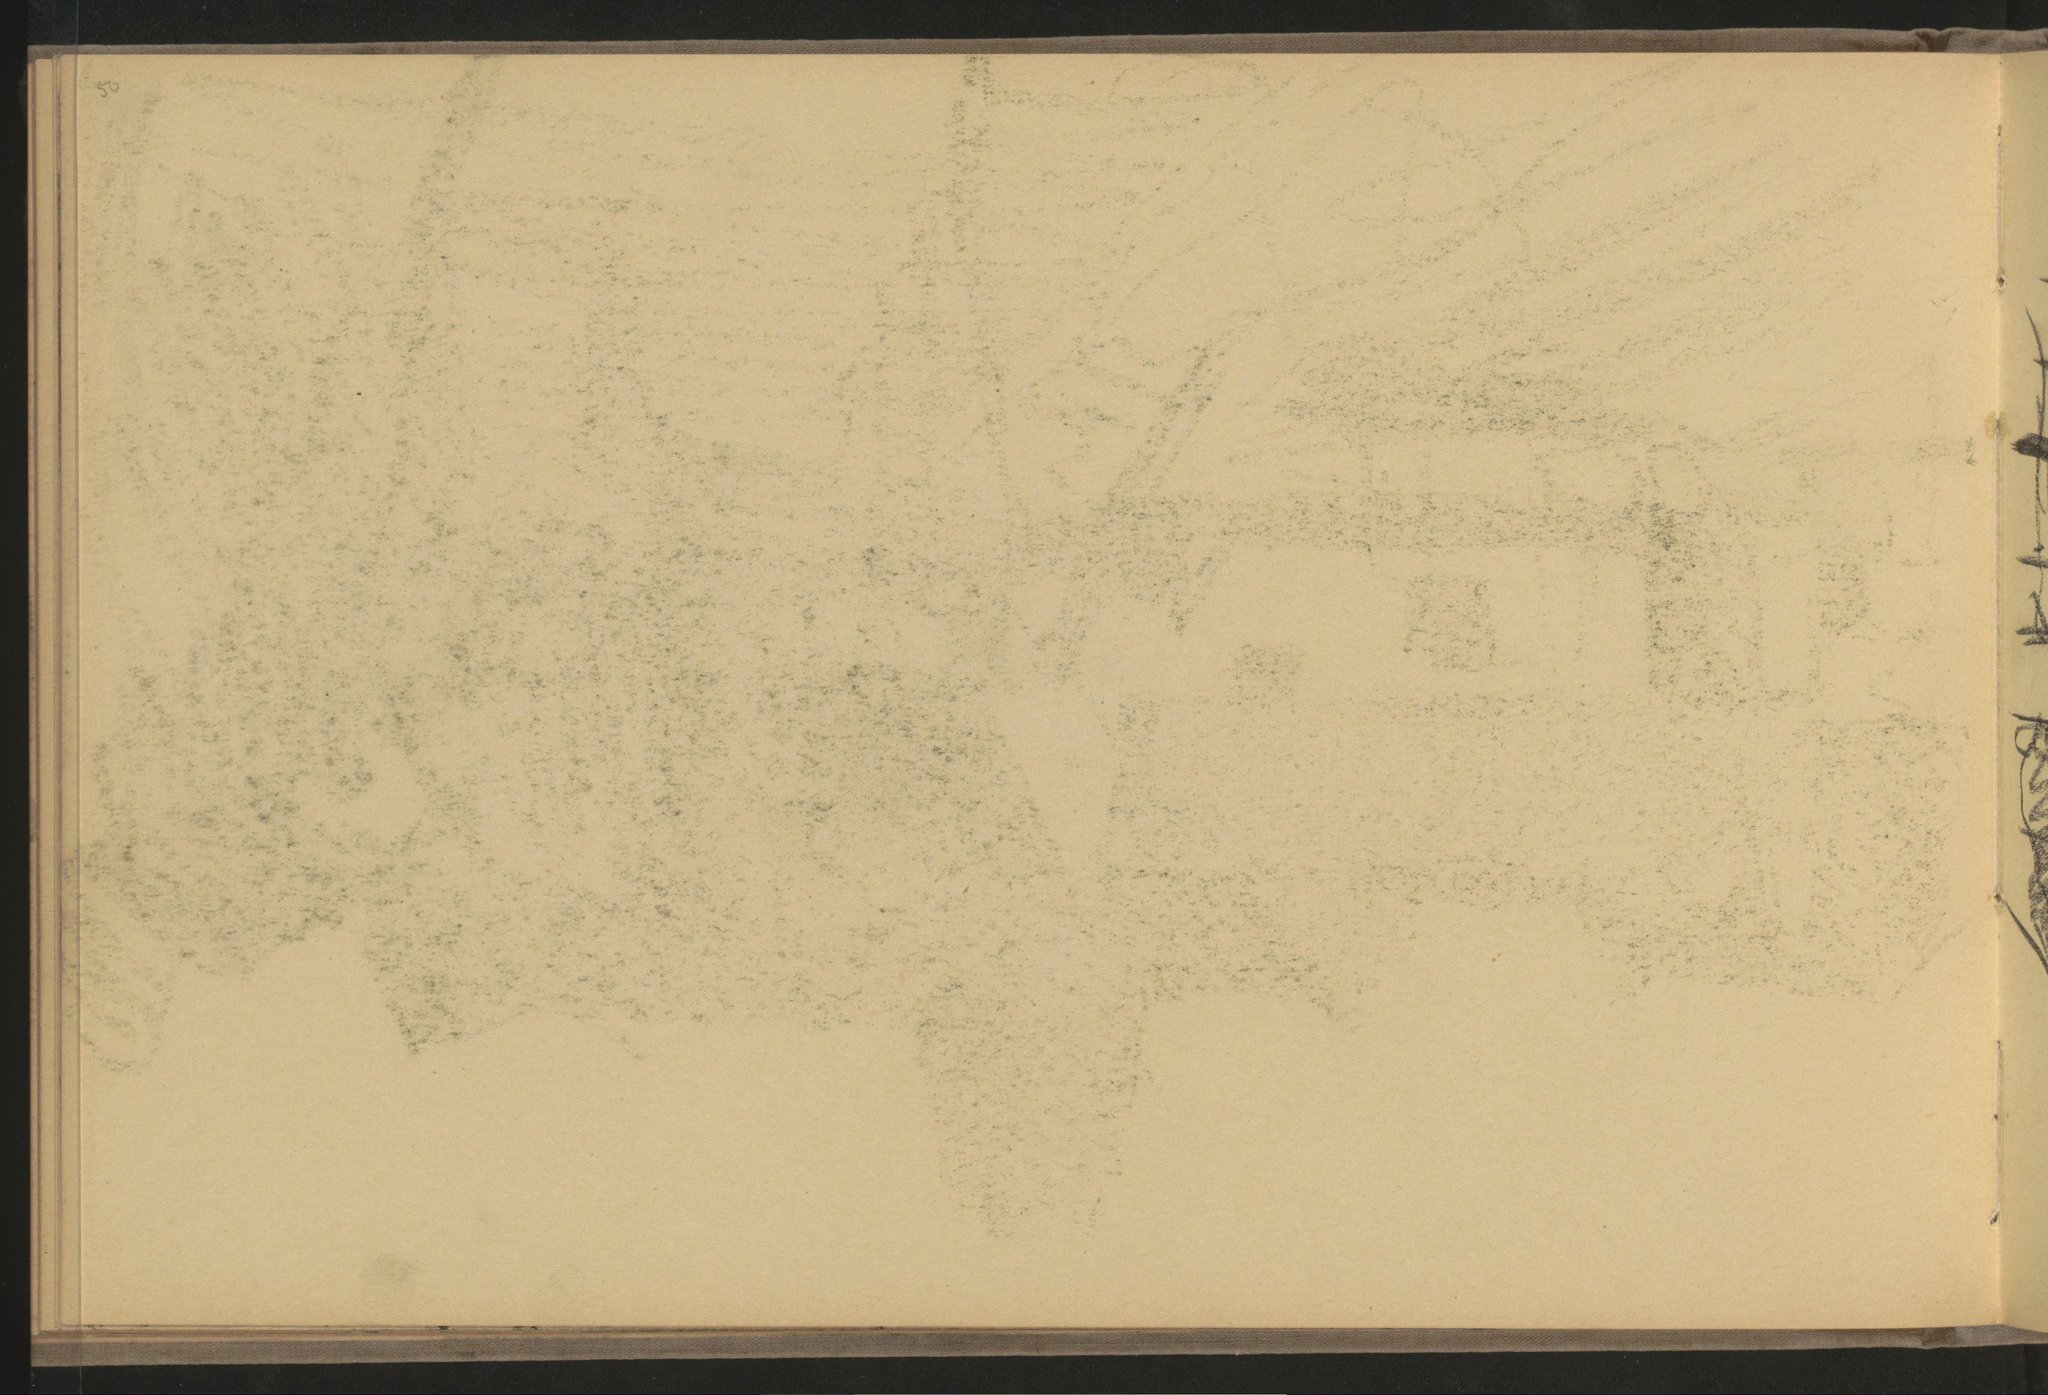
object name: sketchbook leaf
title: Abklatsch van de krijttekening op pagina 51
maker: willem witsen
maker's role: draughtsman, painter, print maker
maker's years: 1860-1923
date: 1901-1907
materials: paper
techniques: printmaking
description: Pagina 50 uit een schetsboek met 60 bladen.